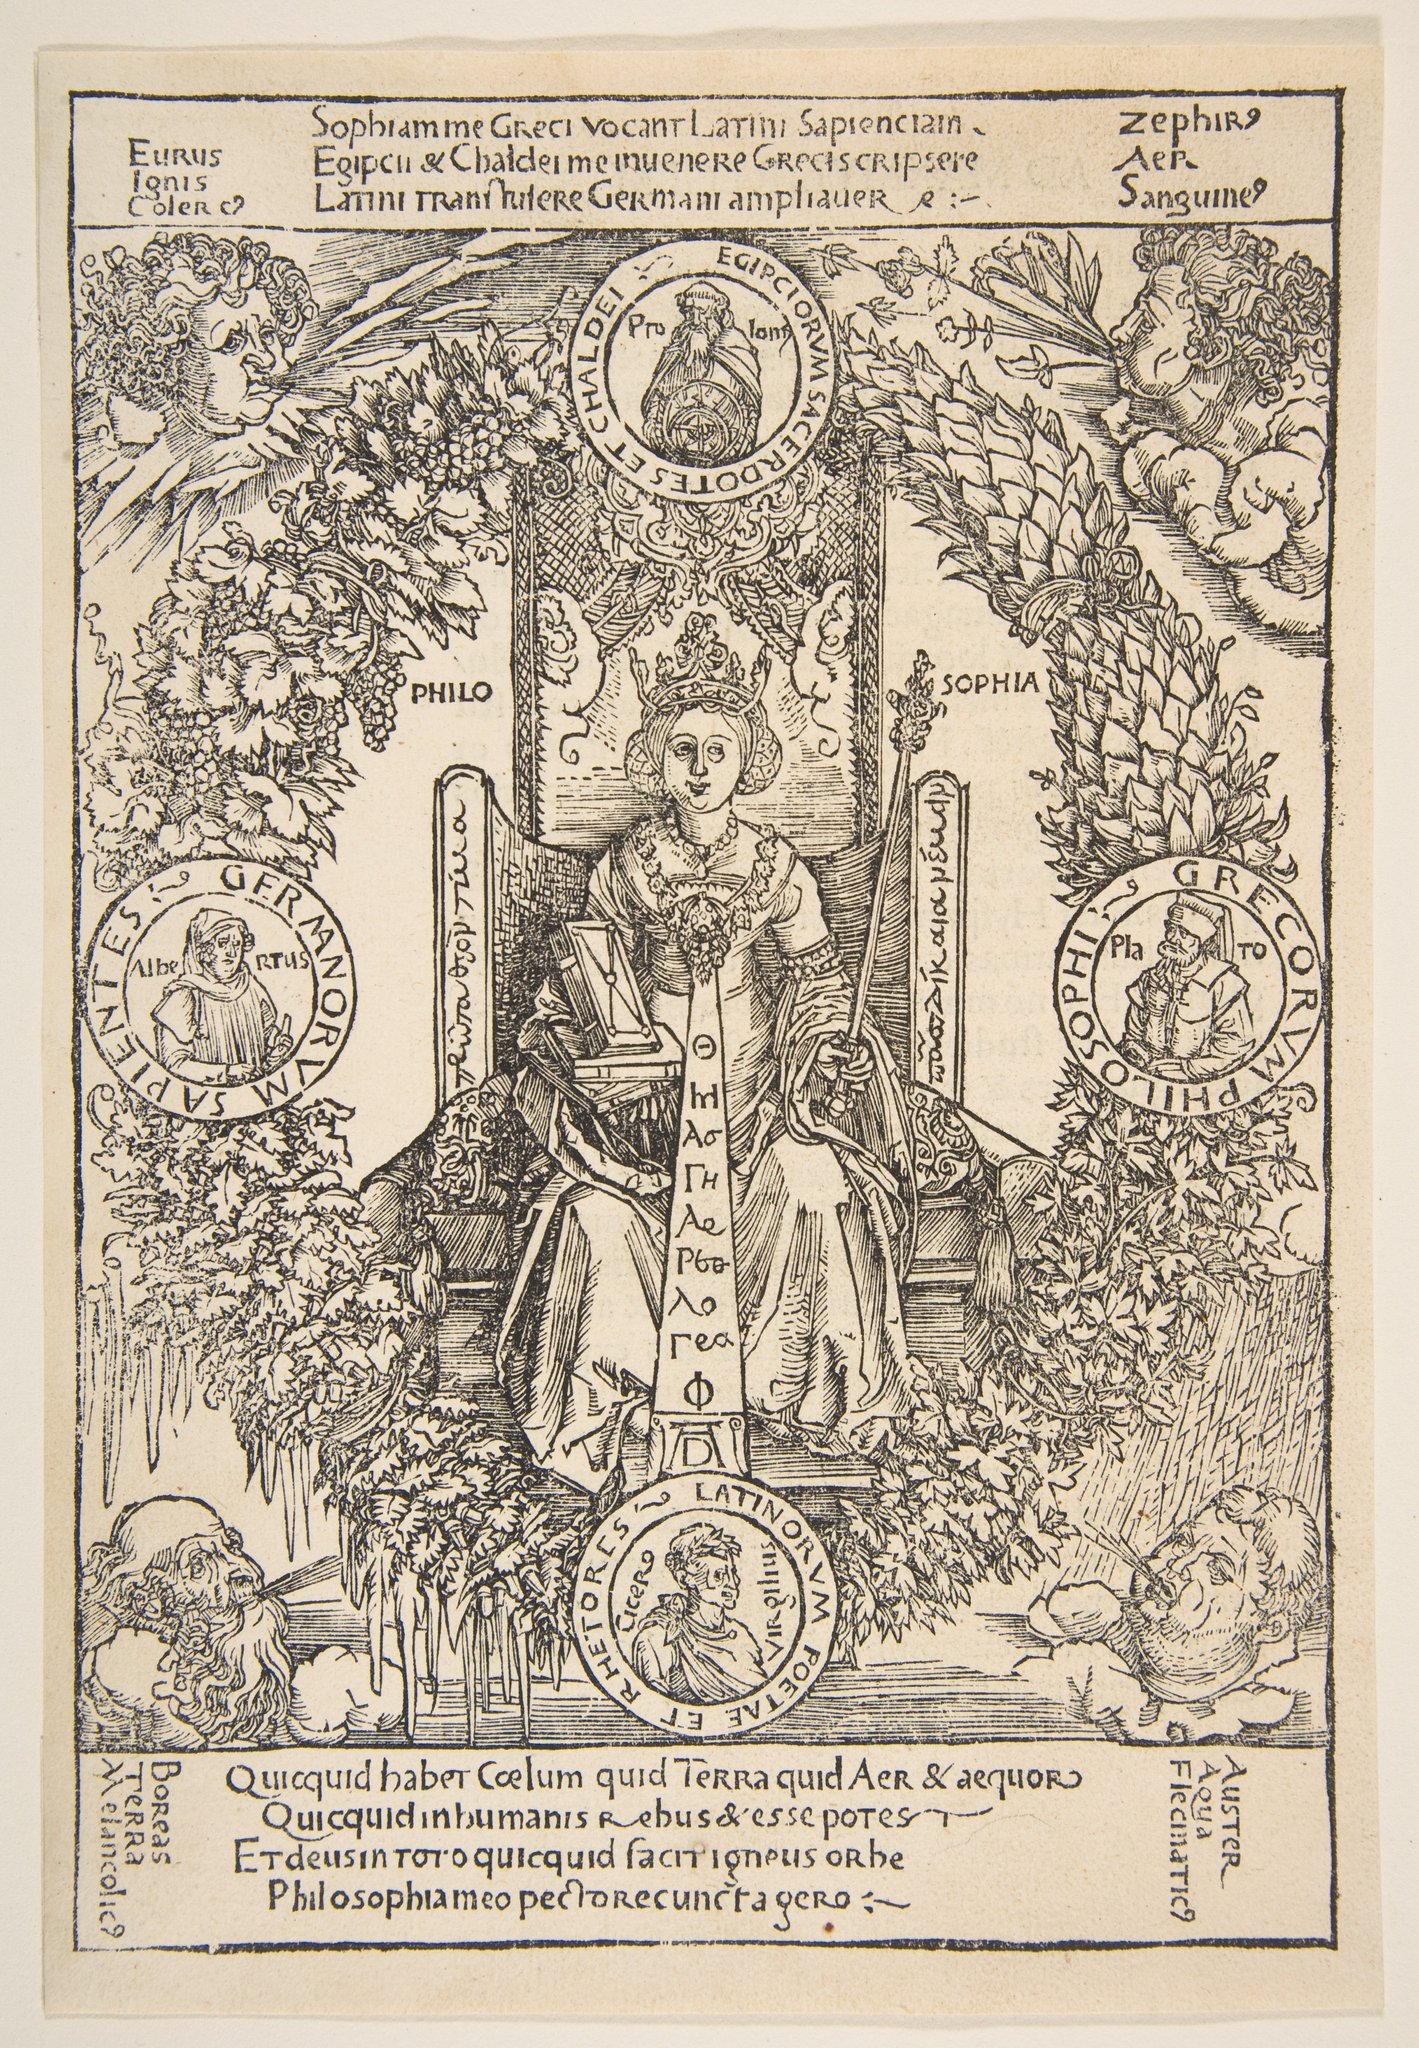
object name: print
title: Philosophy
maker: albrecht dürer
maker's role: artist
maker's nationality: german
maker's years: 1471-1528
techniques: woodcut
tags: men,portraits,women,wreaths